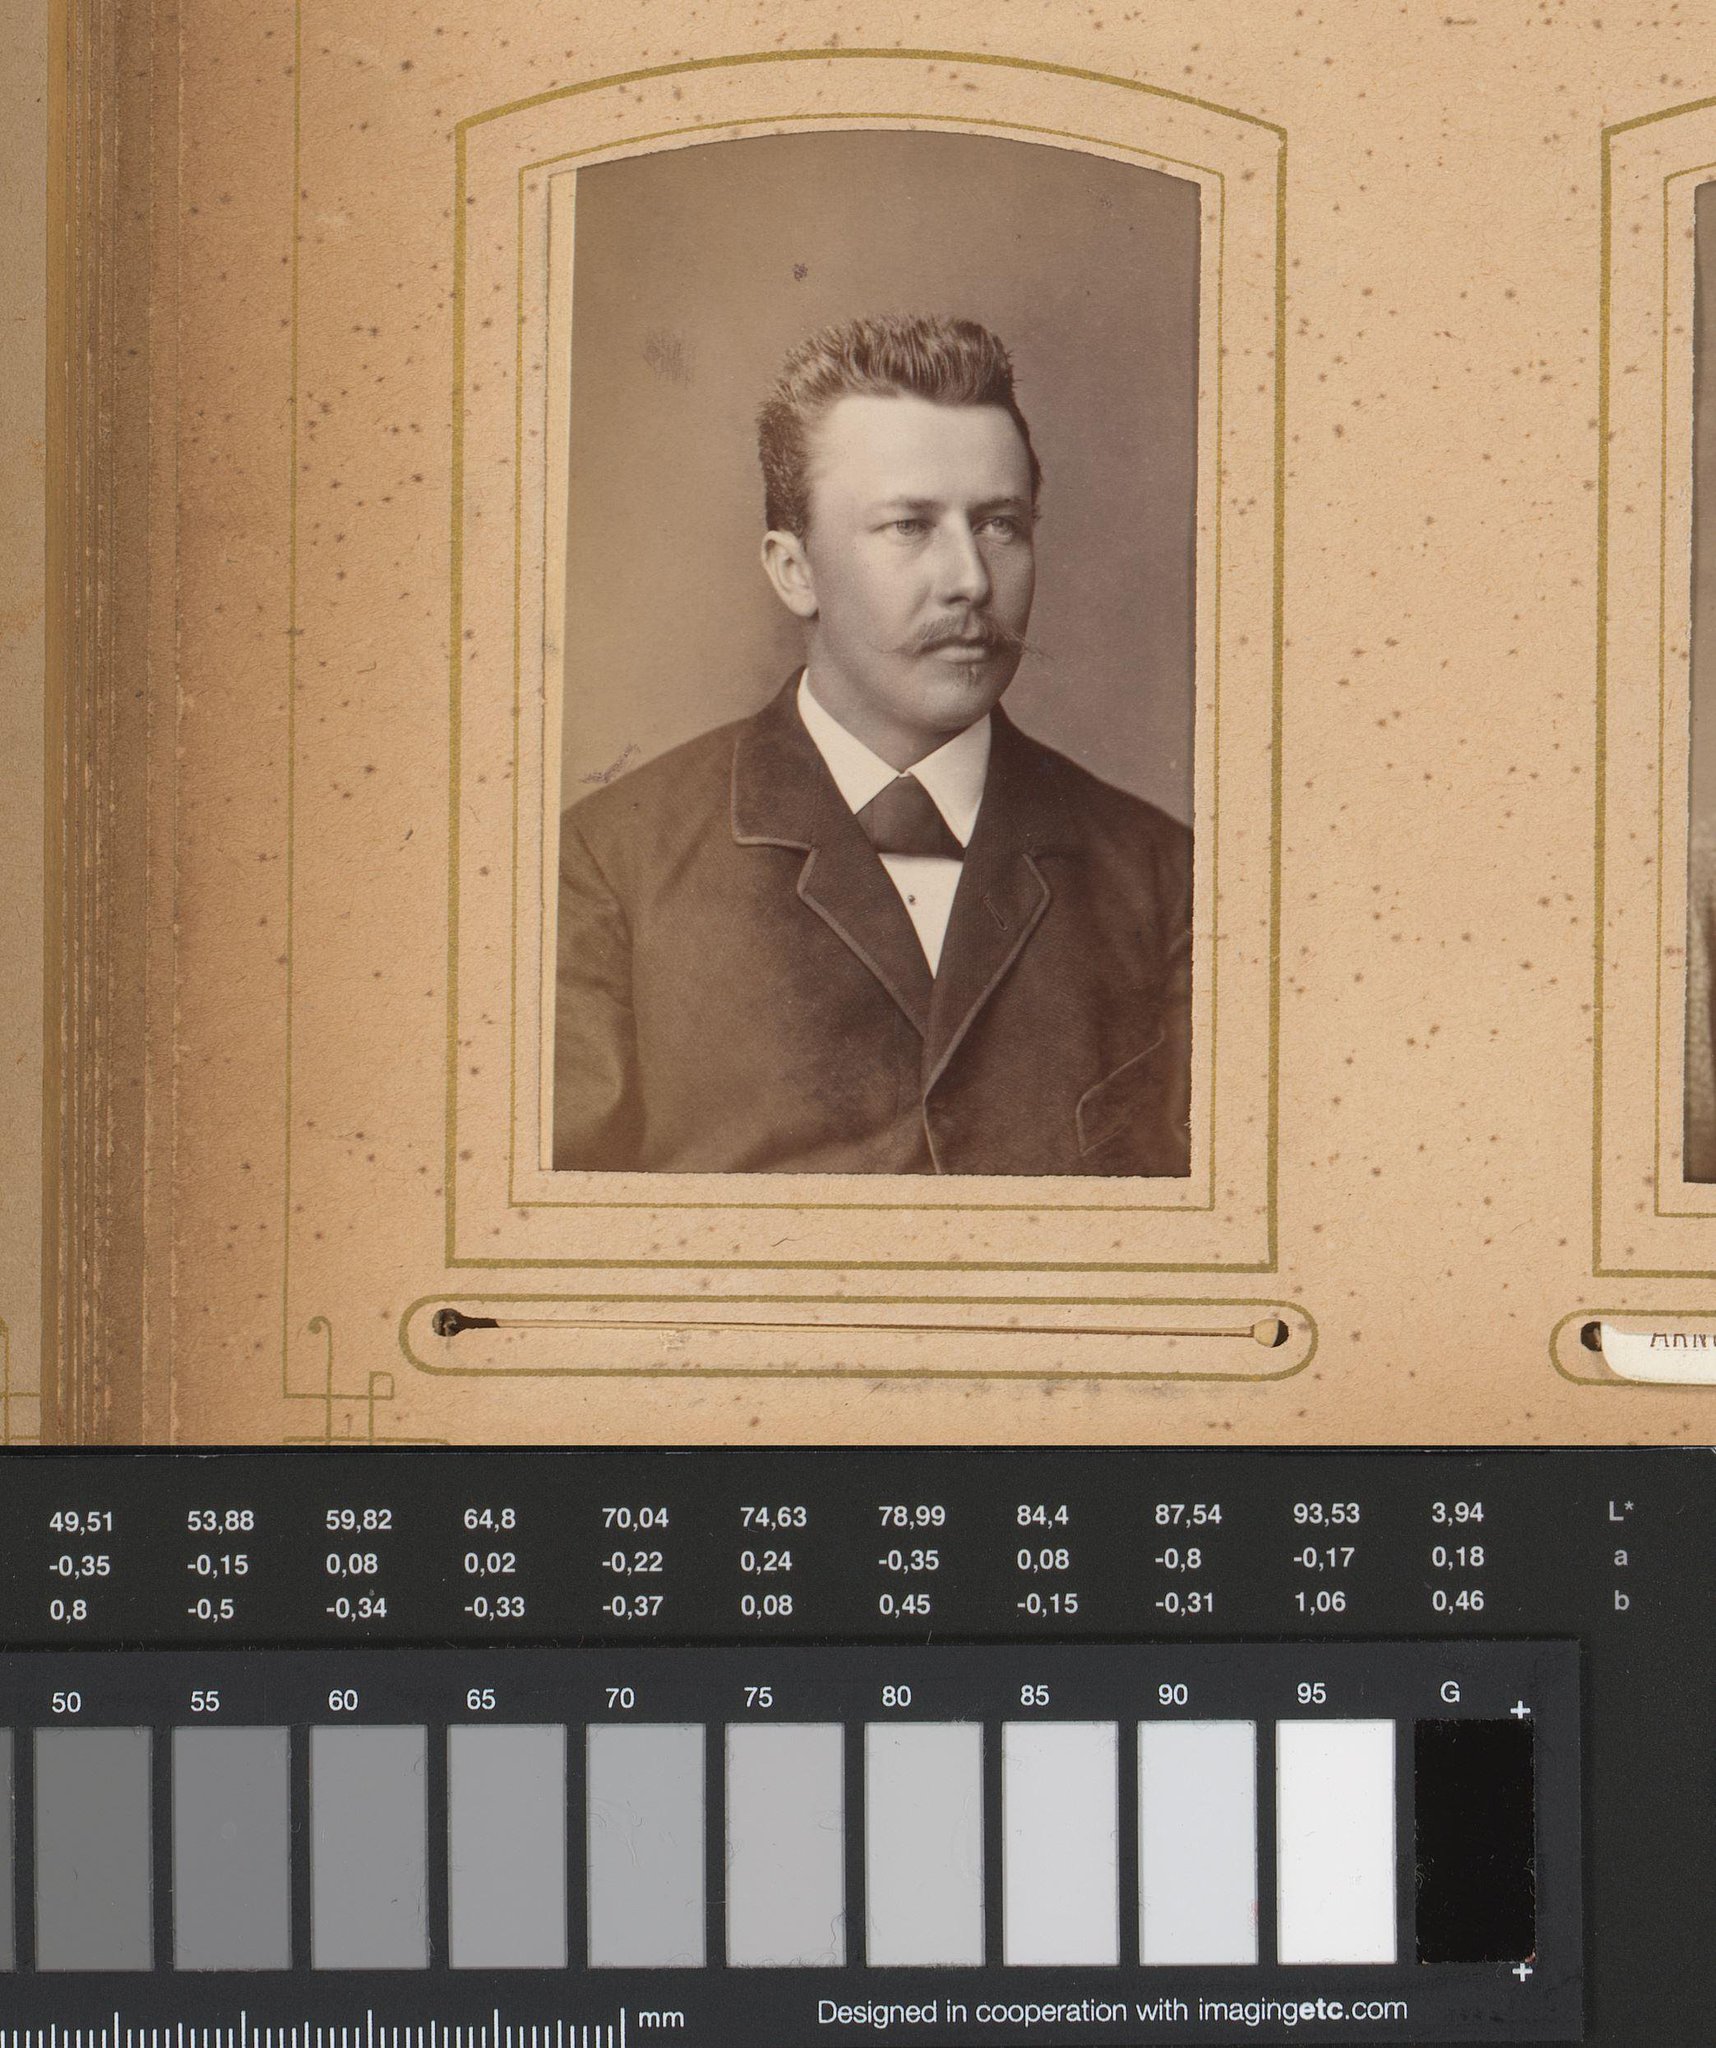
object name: album leaf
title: Portret van een man met snor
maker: Anonymous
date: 1860-1900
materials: cardboard, photographic support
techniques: albumen print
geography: germany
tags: moustache, historical persons